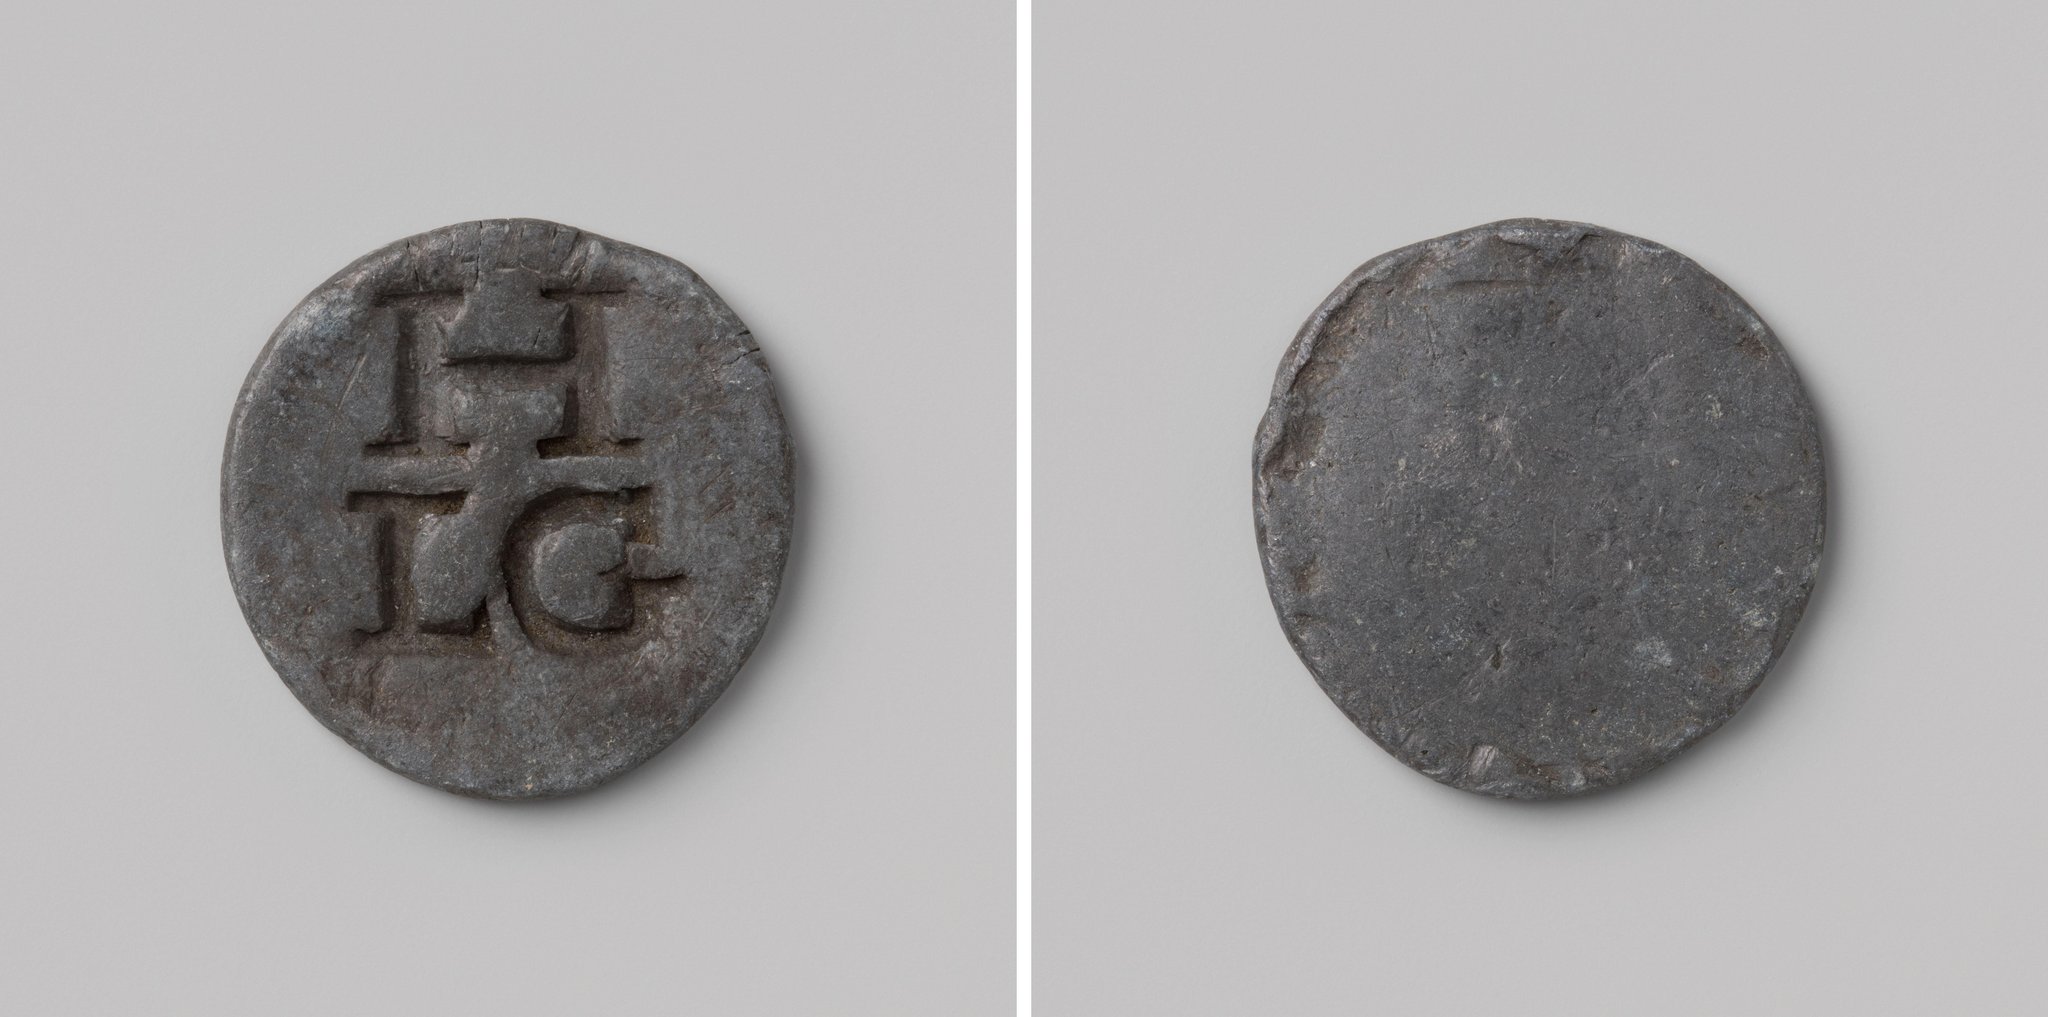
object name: communion token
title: Hersteld Lutherse Gemeente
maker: rensen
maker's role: loodgieter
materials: lead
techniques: casting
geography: amsterdam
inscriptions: inscription: ‘H/ LG’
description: Eenzijdige loden penning. Voorzijde: letter H boven letters LG. Keerzijde: blanco.